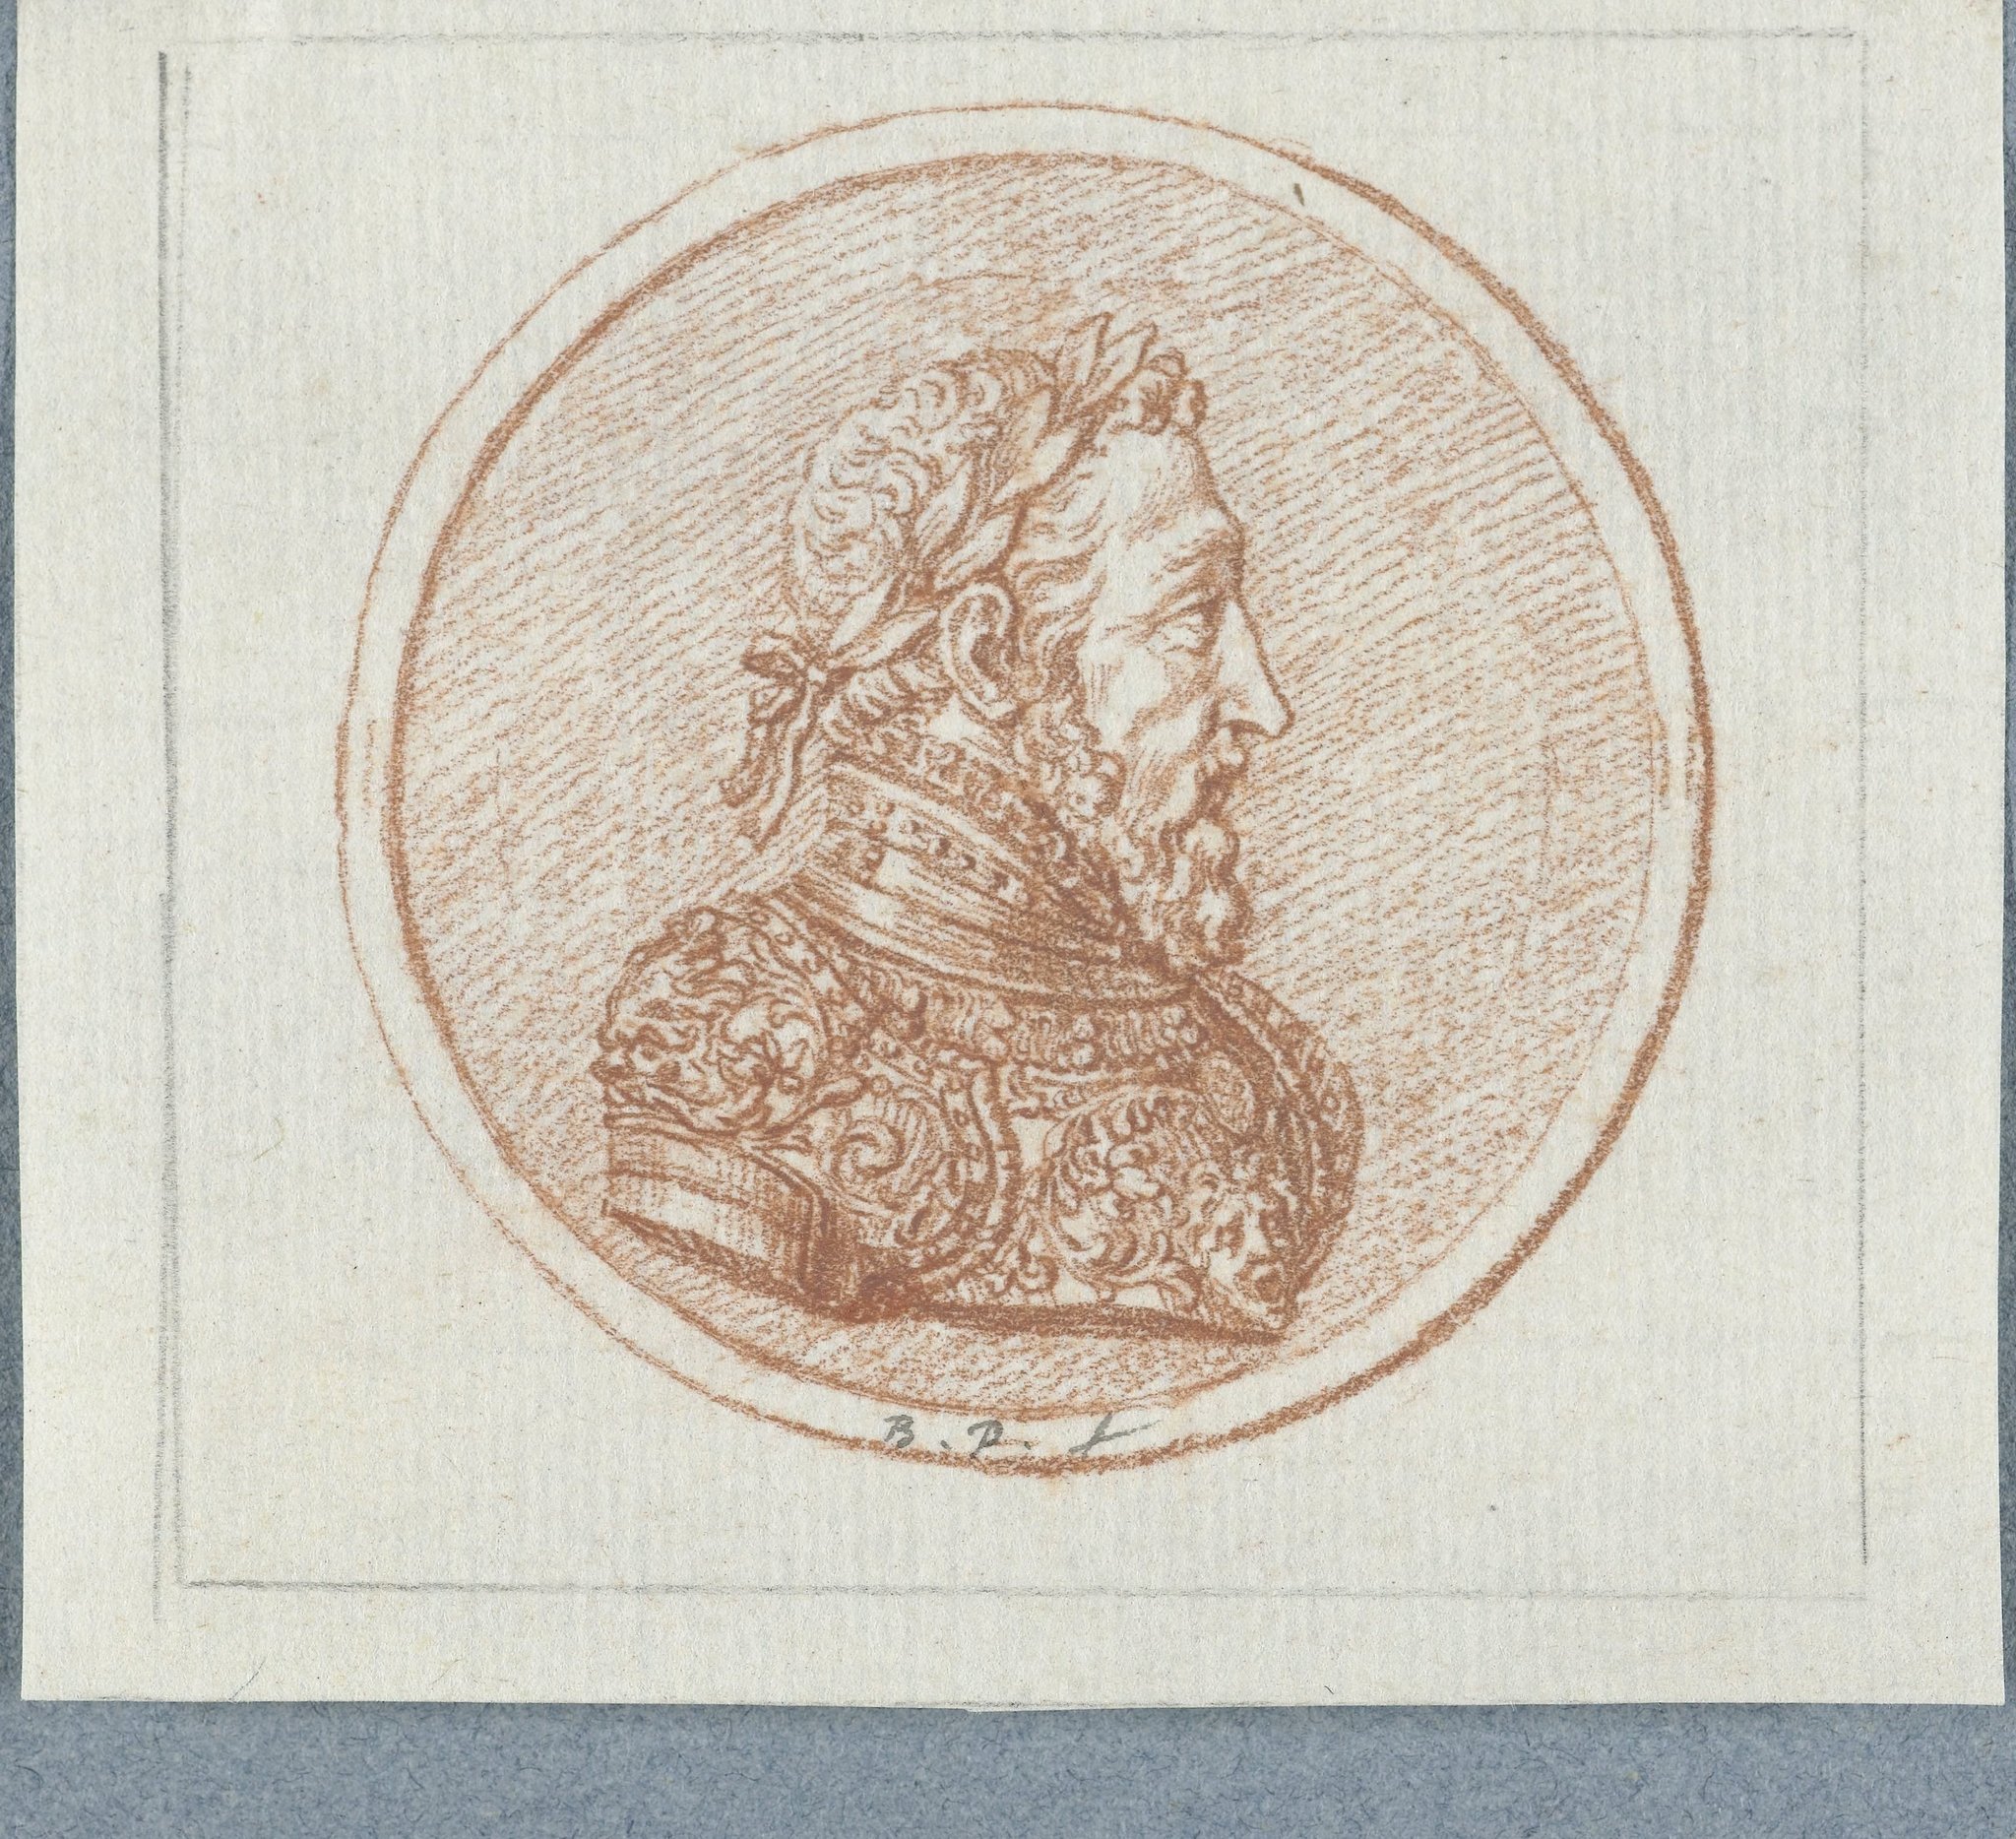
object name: design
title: Penning met portret van Hendrik II, koning van Frankrijk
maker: bernard picart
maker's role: draughtsman, print maker, publisher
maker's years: 1673-1733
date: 1683-1733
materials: chalk, paper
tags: historical persons, medal (considered as a piece of sculpture, regardless of its specific function)